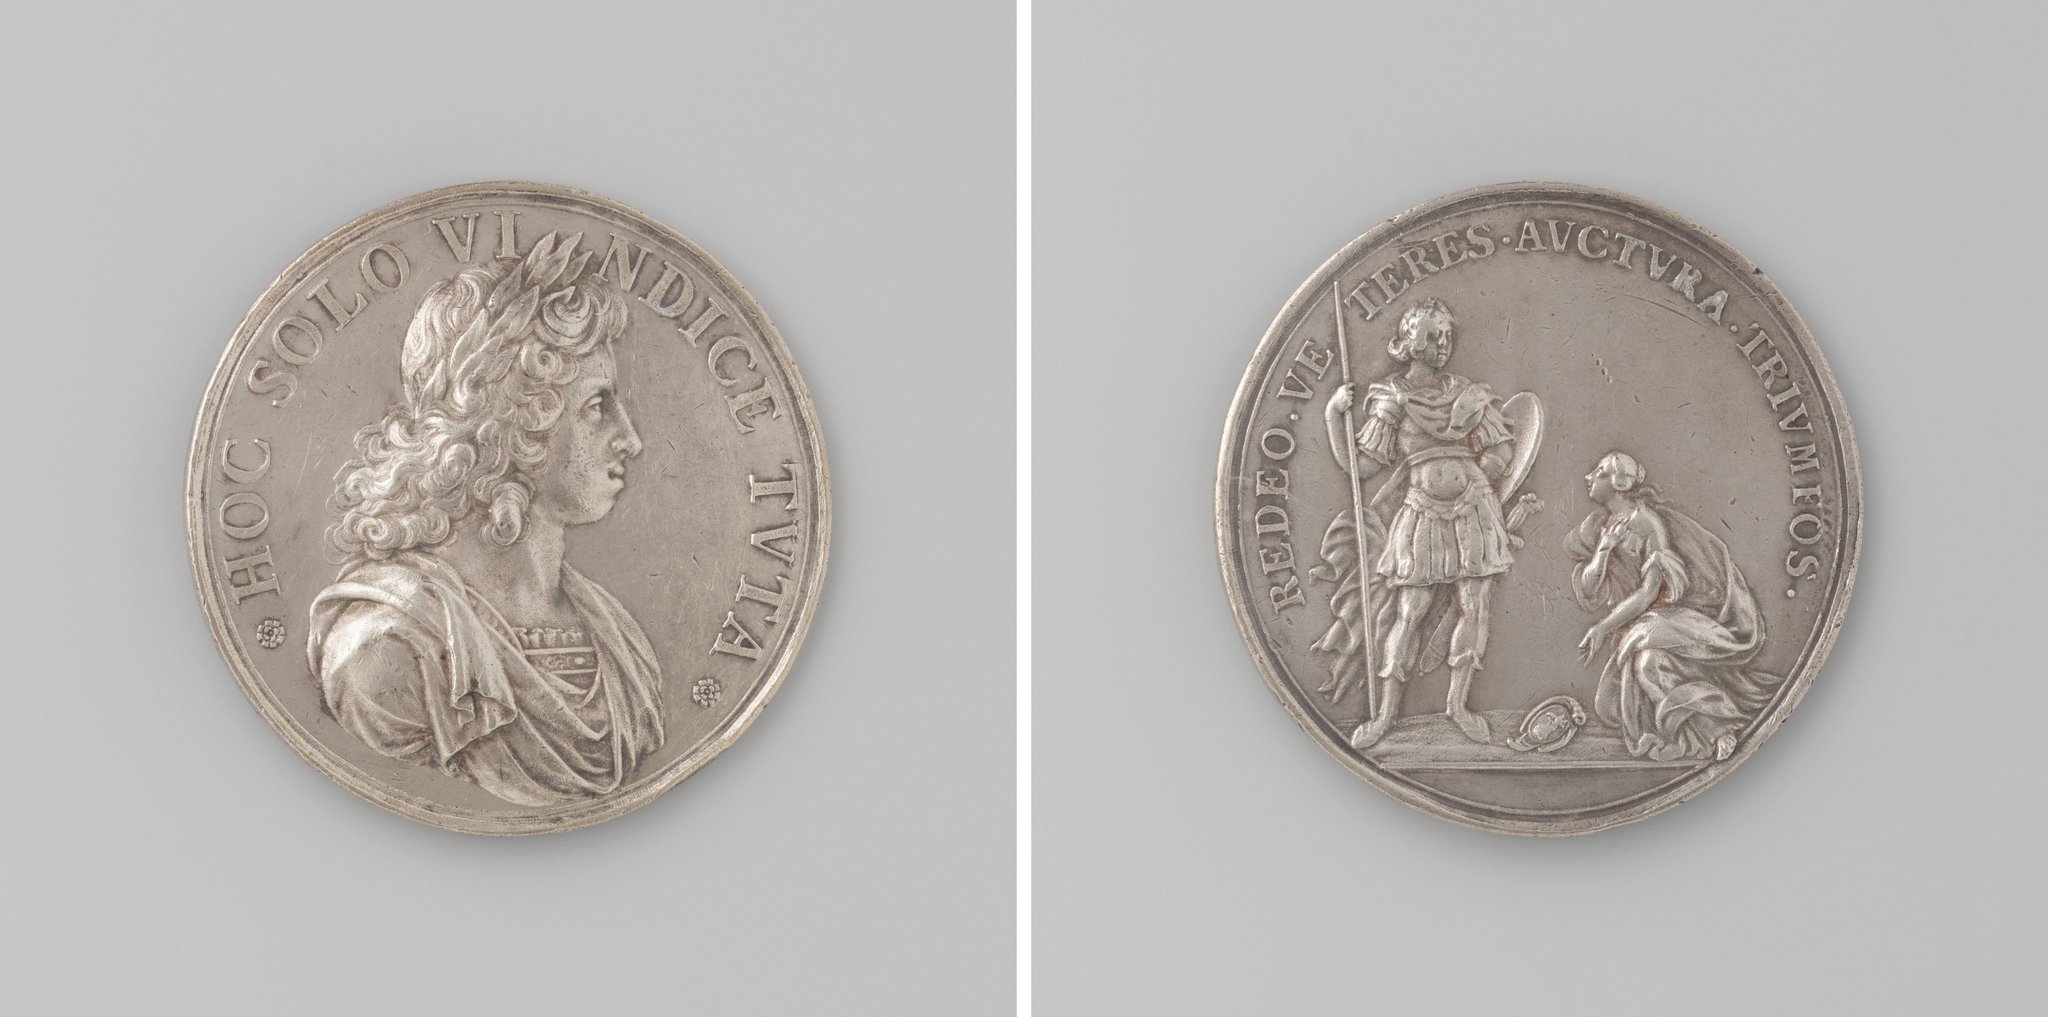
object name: history medal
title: Schonen herenigd met Zweden na de vrede van Fontainebleau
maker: arvid karlsteen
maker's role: medailleur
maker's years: 1647-1718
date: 1679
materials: silver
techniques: striking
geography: stockholm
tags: koning, karel xi (koning van zweden), île-de-france, zweden, fontainebleau, skåne (provincie), vrede van fontainebleau (1679)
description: Zilveren penning. Voorzijde: borststuk man met lauwerkrans binnen omschrift. Keerzijde: Schonen geknield voor koning in Romeins tenue om hem wapenschild aan te bieden binnen omschrift